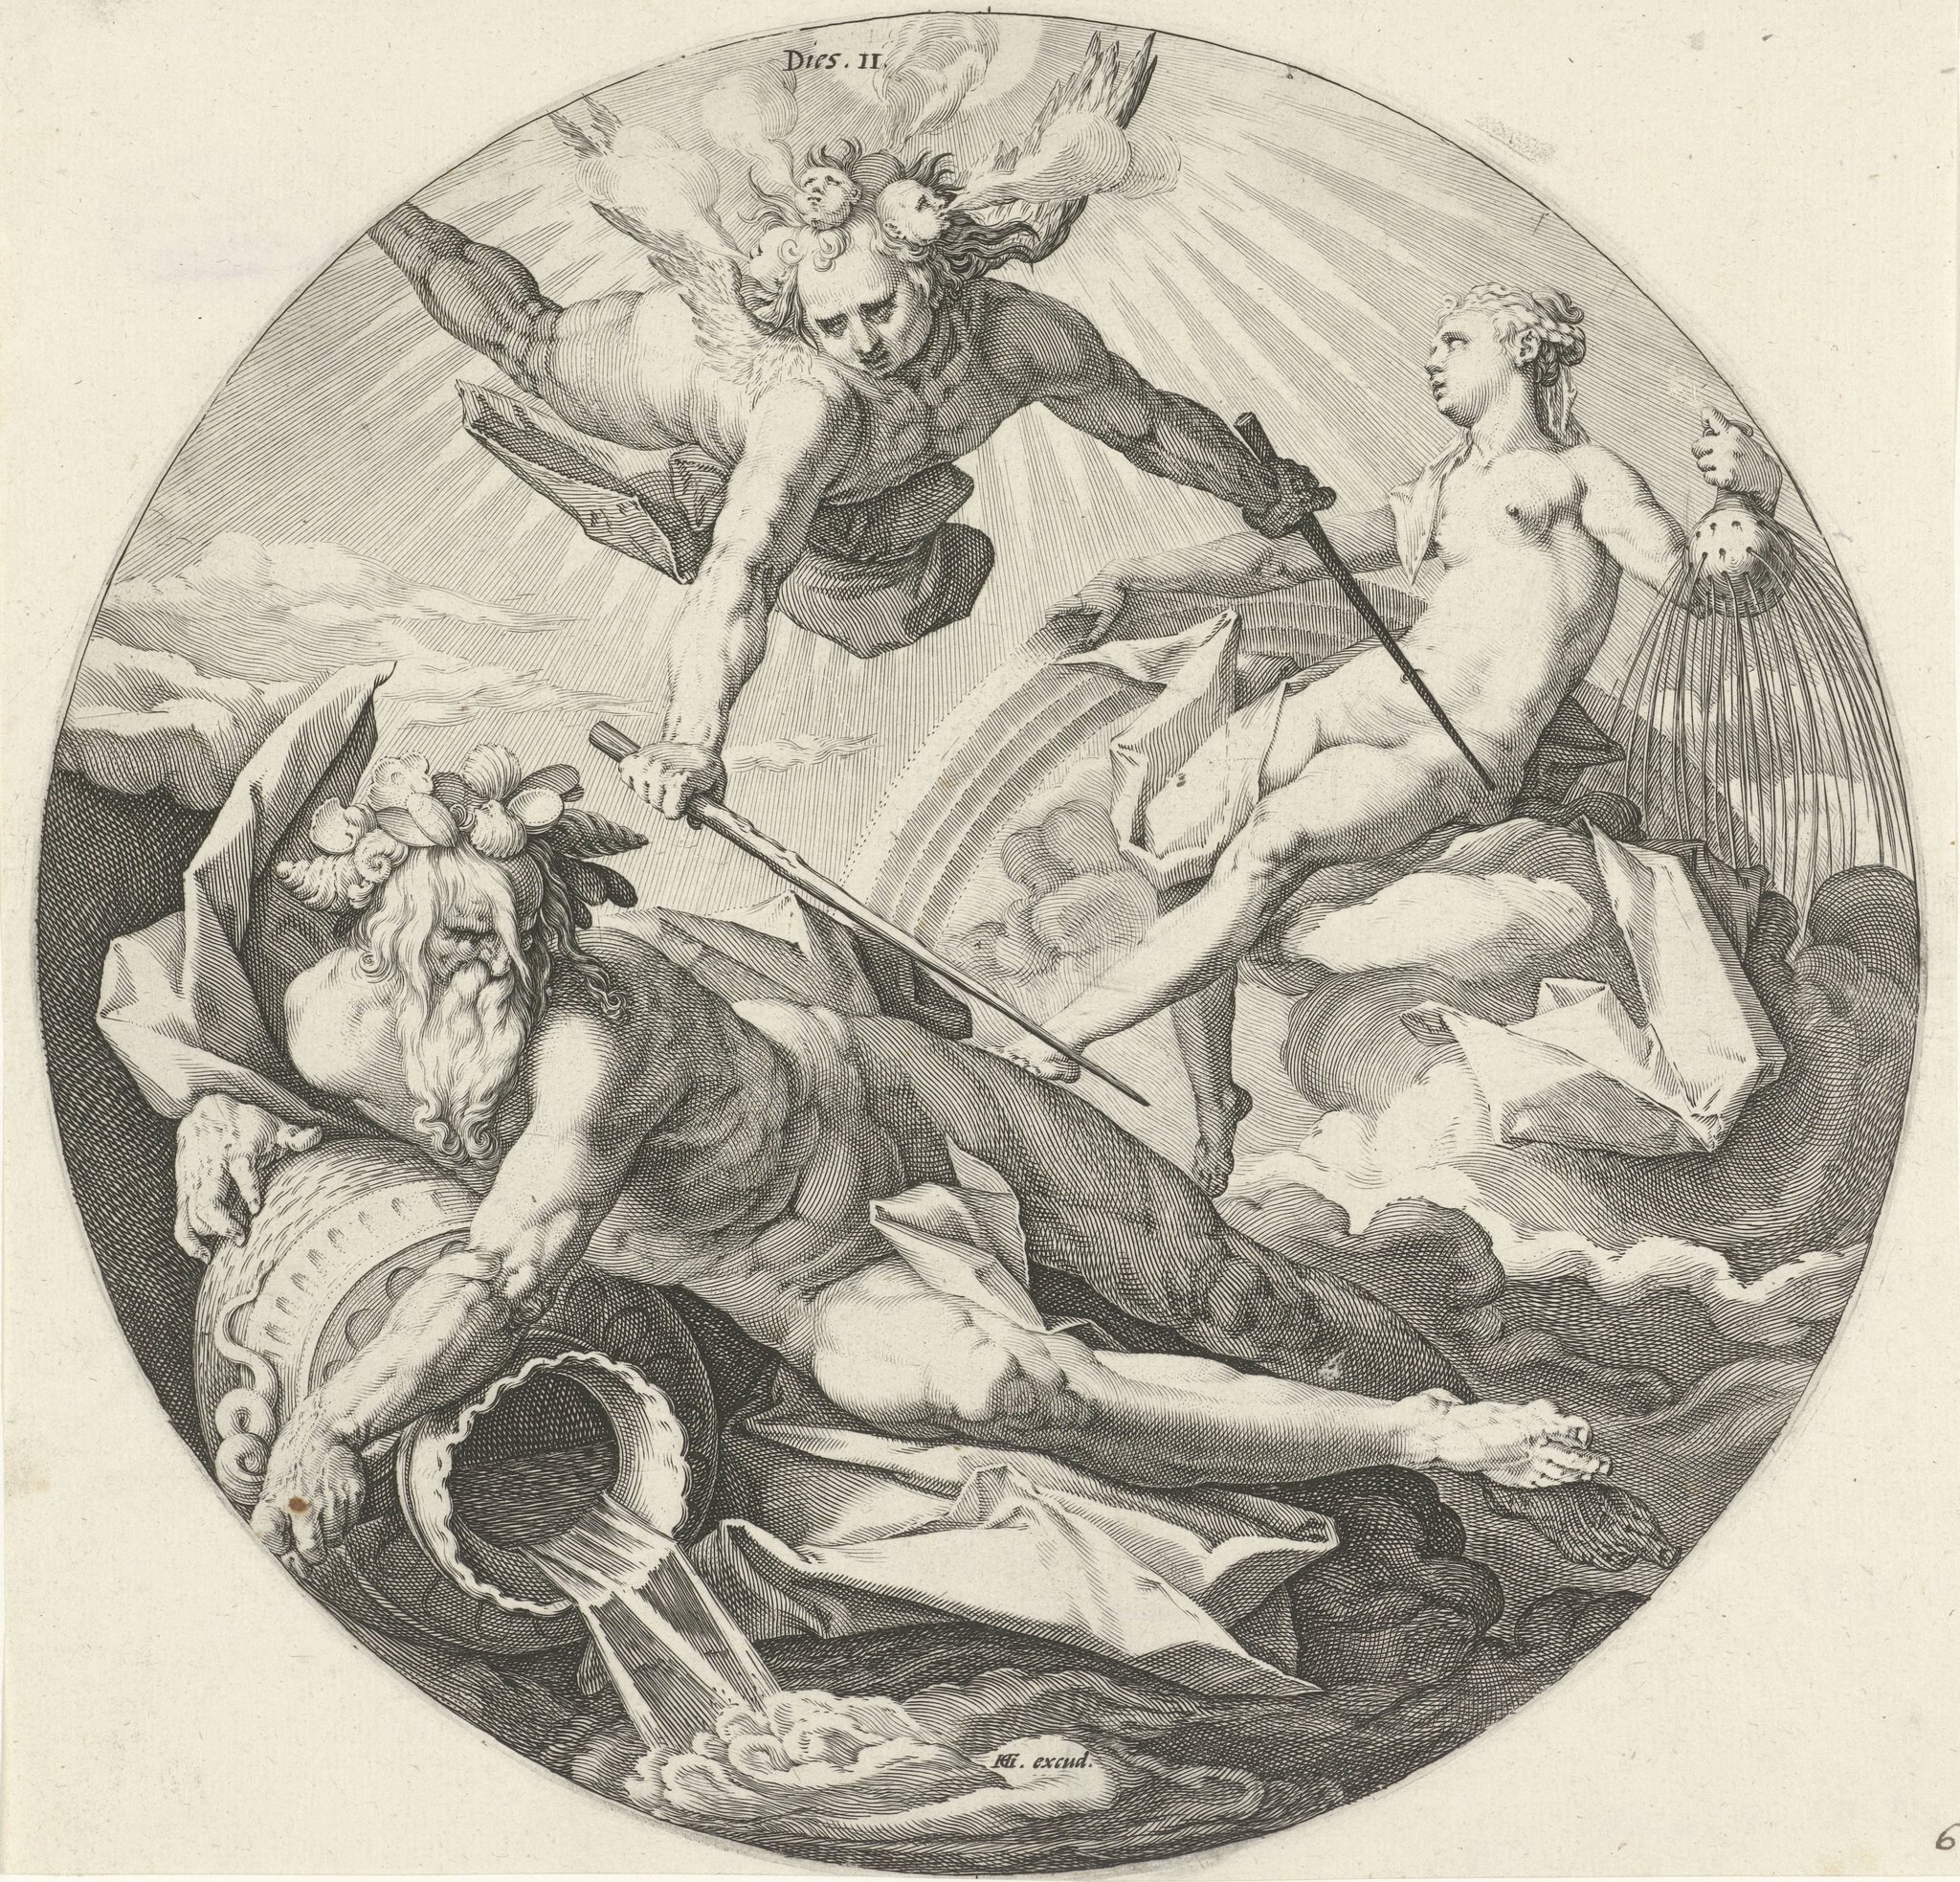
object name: print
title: Schepping van de wereld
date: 1589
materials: paper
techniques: engraving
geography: amsterdam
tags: creation of the firmament and division of the waters above and below it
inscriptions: number: ‘6’, collector's mark: Lugt 10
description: De tweede scheppingsdag: een engel, op zijn hoofd de vier winden, scheidt het hemelwater van het water van de aarde. Het hemelwater wordt gepersonifieerd door een vrouw met een karaf in haar hand, waaruit water stroomt. In haar andere hand de regenboog. Het water van de aarde wordt gepersonifieerd door een stroomgod, met een kruik waaruit water stroomt. Op zijn hoofd schelpen. Naar de Bijbeltekst in Gen. 1:6-8.